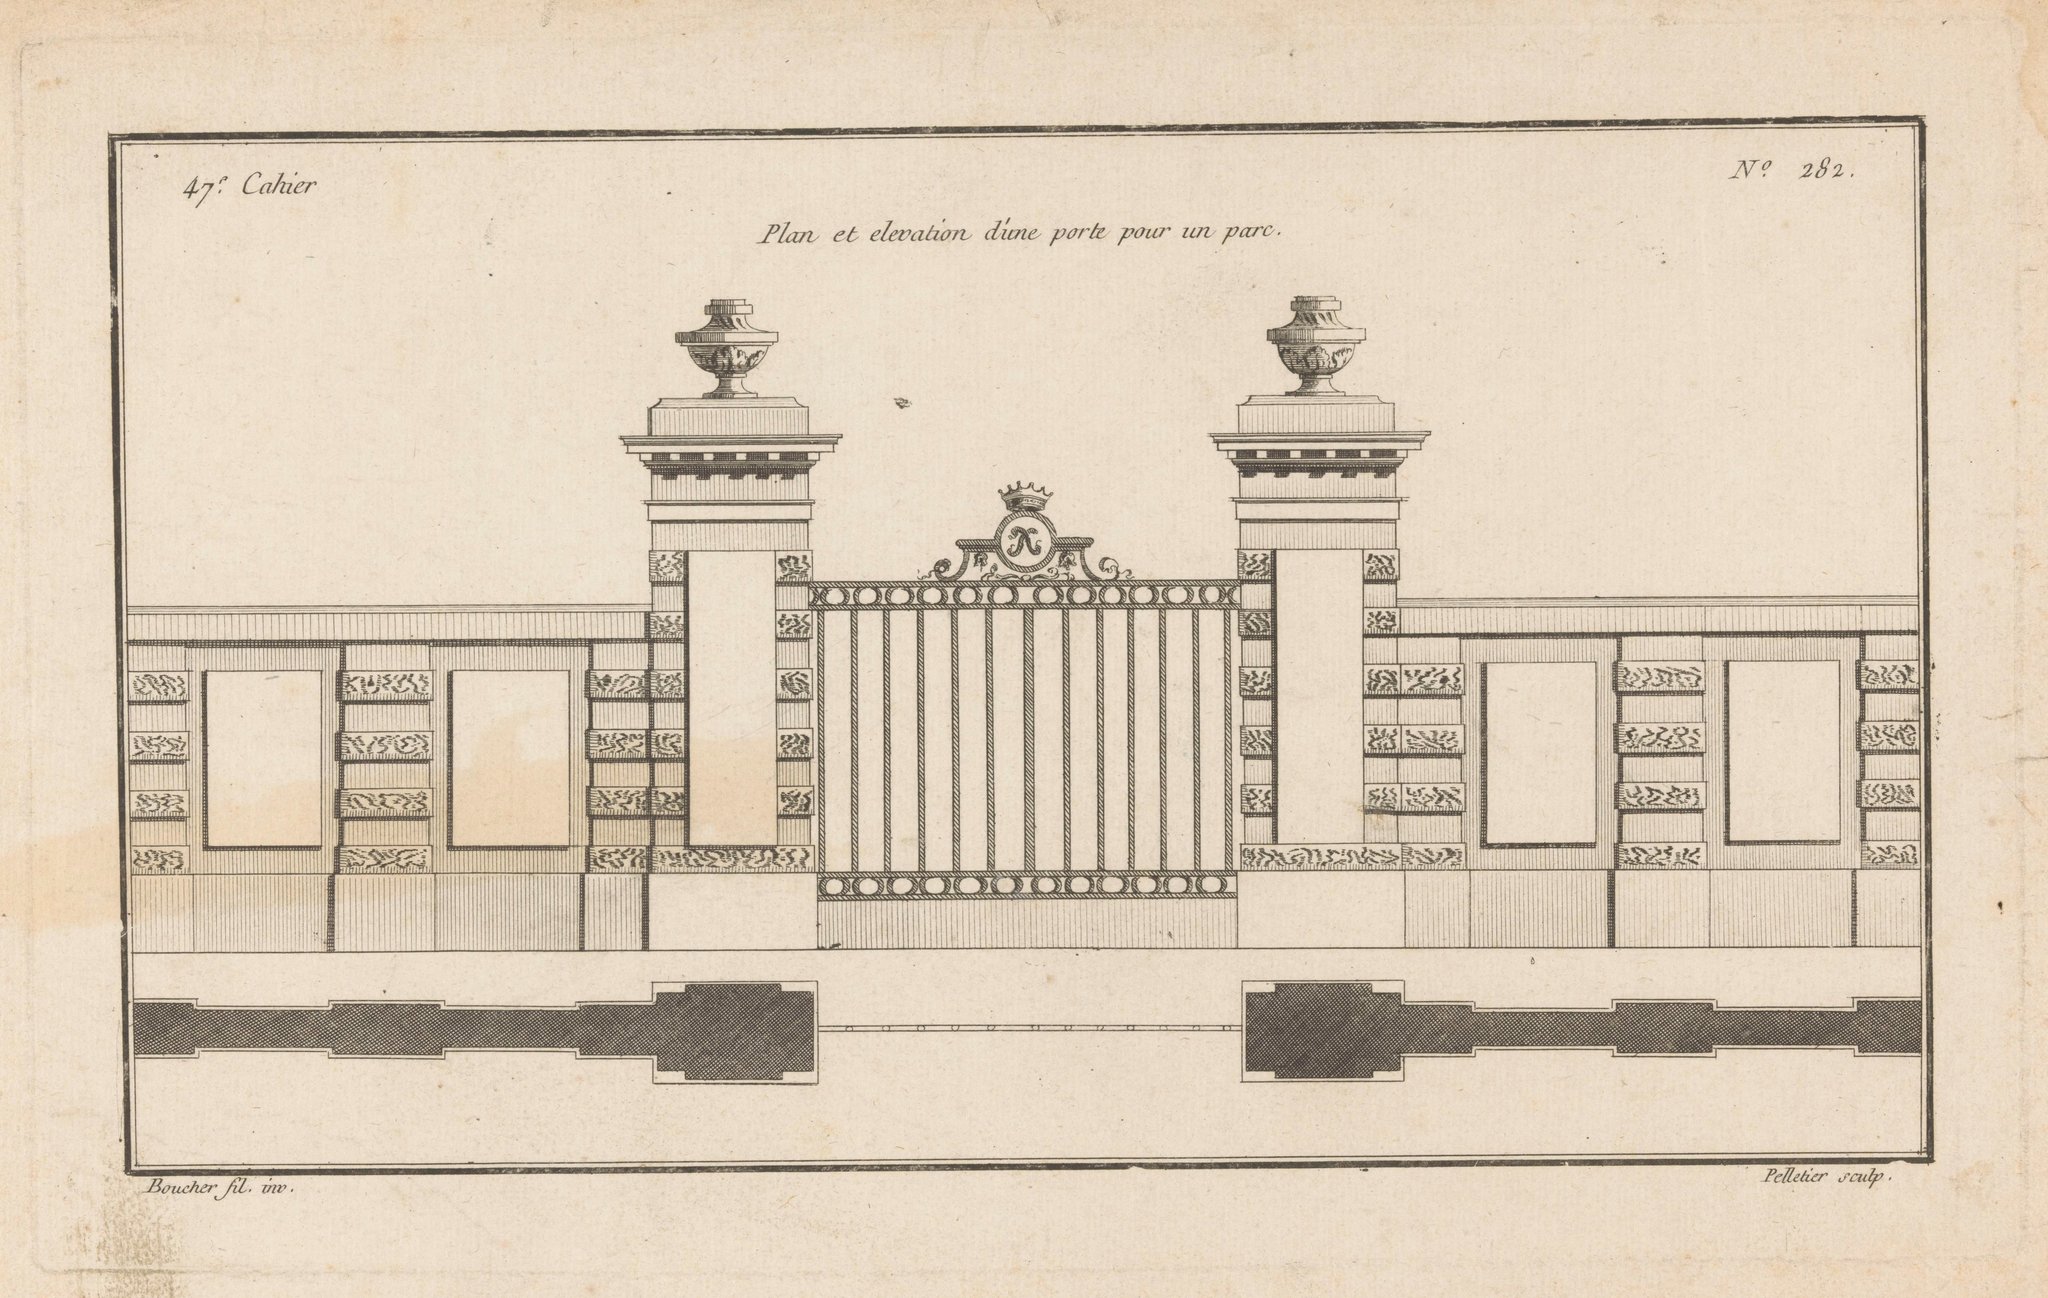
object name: print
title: Poort met hekwerk en vazen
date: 1772-1779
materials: paper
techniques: engraving, etching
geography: paris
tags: vase ~ ornament, fence, wall, paling, gate, entrance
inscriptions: collector's mark: Lugt 2228, collector's mark: Lugt 2760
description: Een poort van een park met een hekwerk met vazen aan weerszijden. Prentnummer 282.